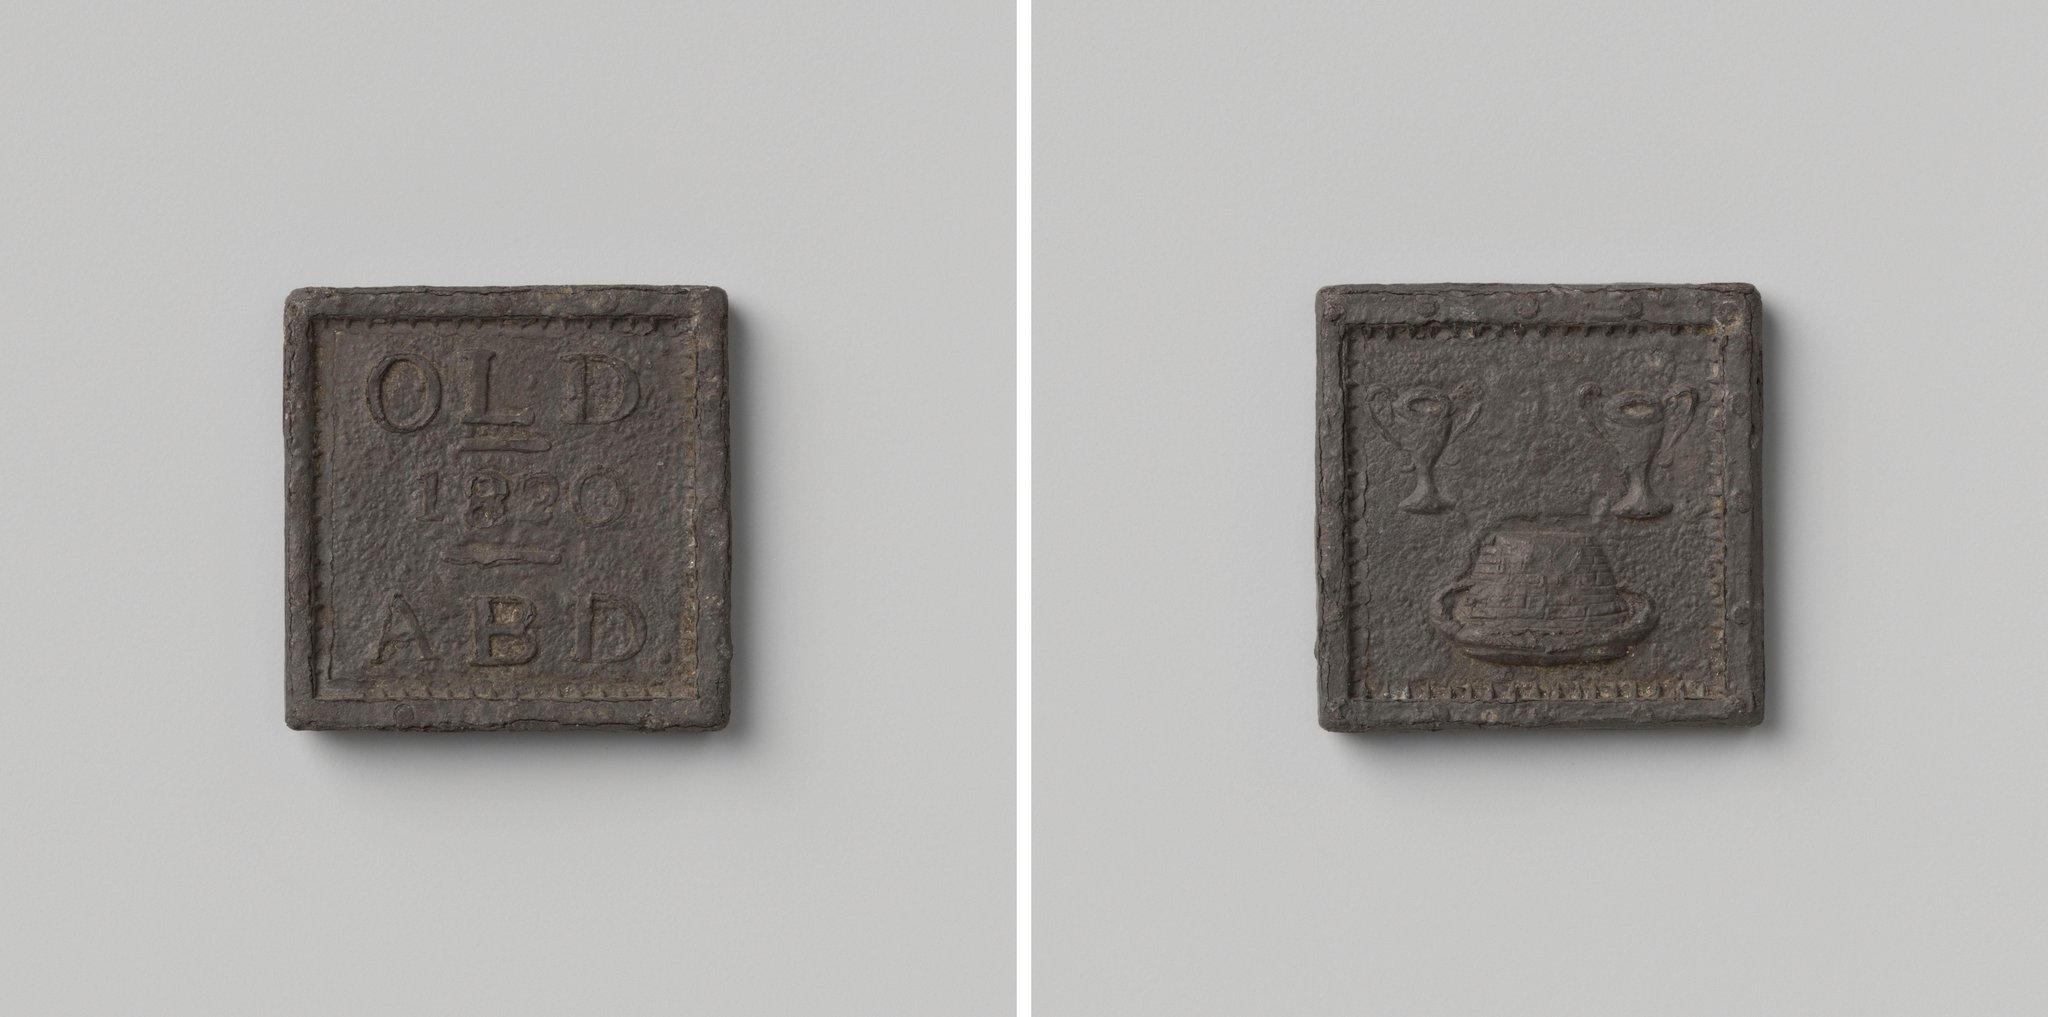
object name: medal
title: Penning met opschrift OLD ABD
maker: Anonymous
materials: lead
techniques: casting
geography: netherlands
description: Loden vierkante penning. Voorzijde: opschrift: OLD en ABD; daartussen jaartal. Keerzijde: twee vazen boven hoed